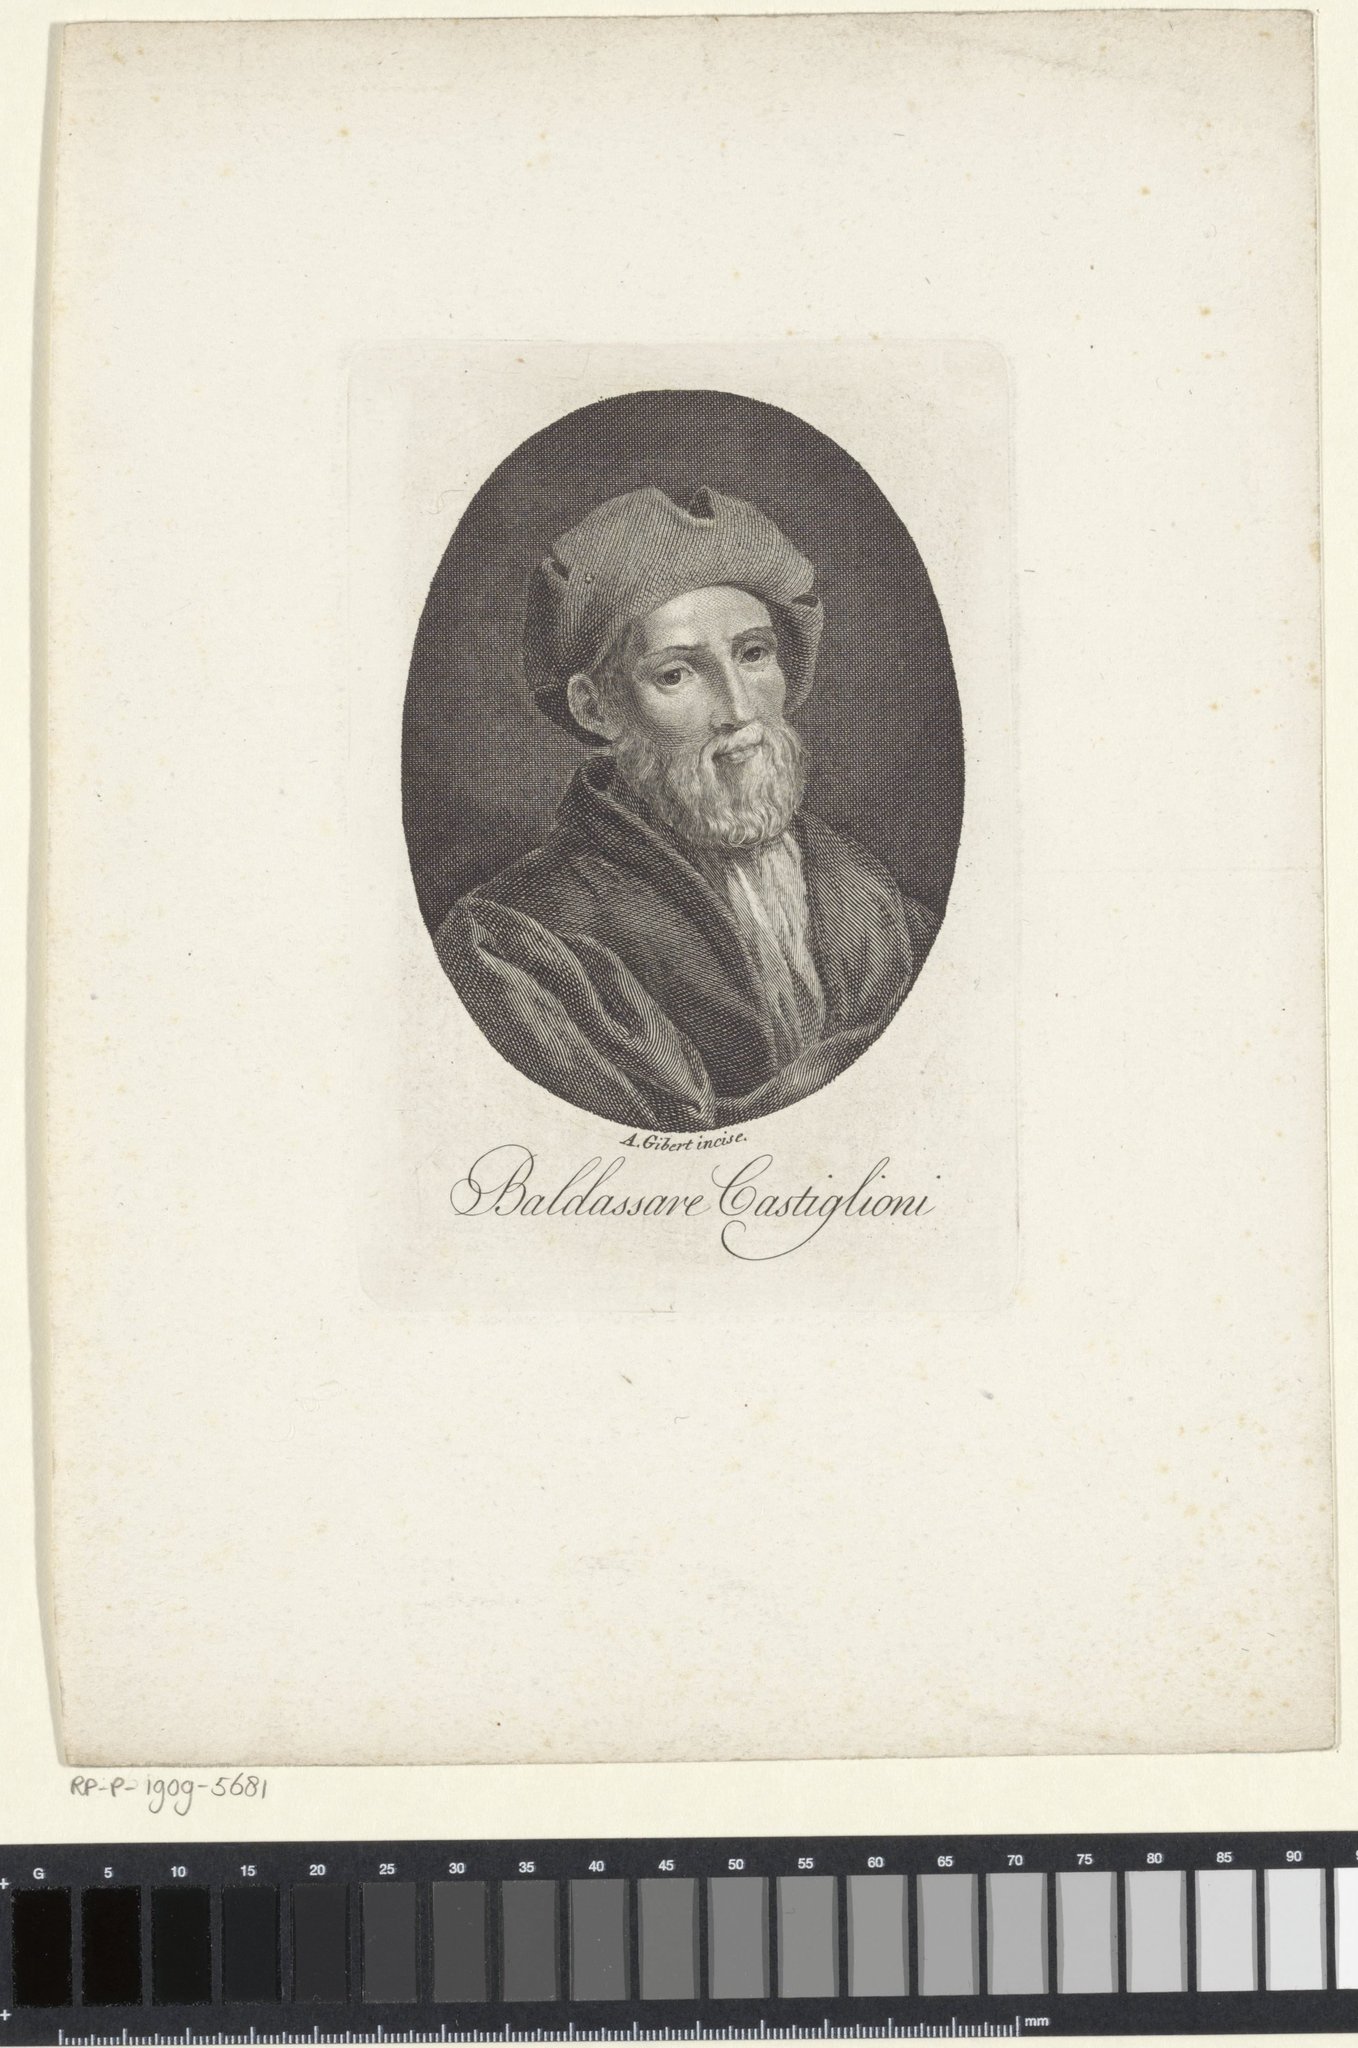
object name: print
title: Portret van de dichter Baldassare Castiglione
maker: antonio ghiberti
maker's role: print maker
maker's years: 1798-1867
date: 1808-1867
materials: paper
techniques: engraving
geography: italy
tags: historical persons, portrait of a writer, writer, poet, author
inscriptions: collector's mark: Lugt 2228